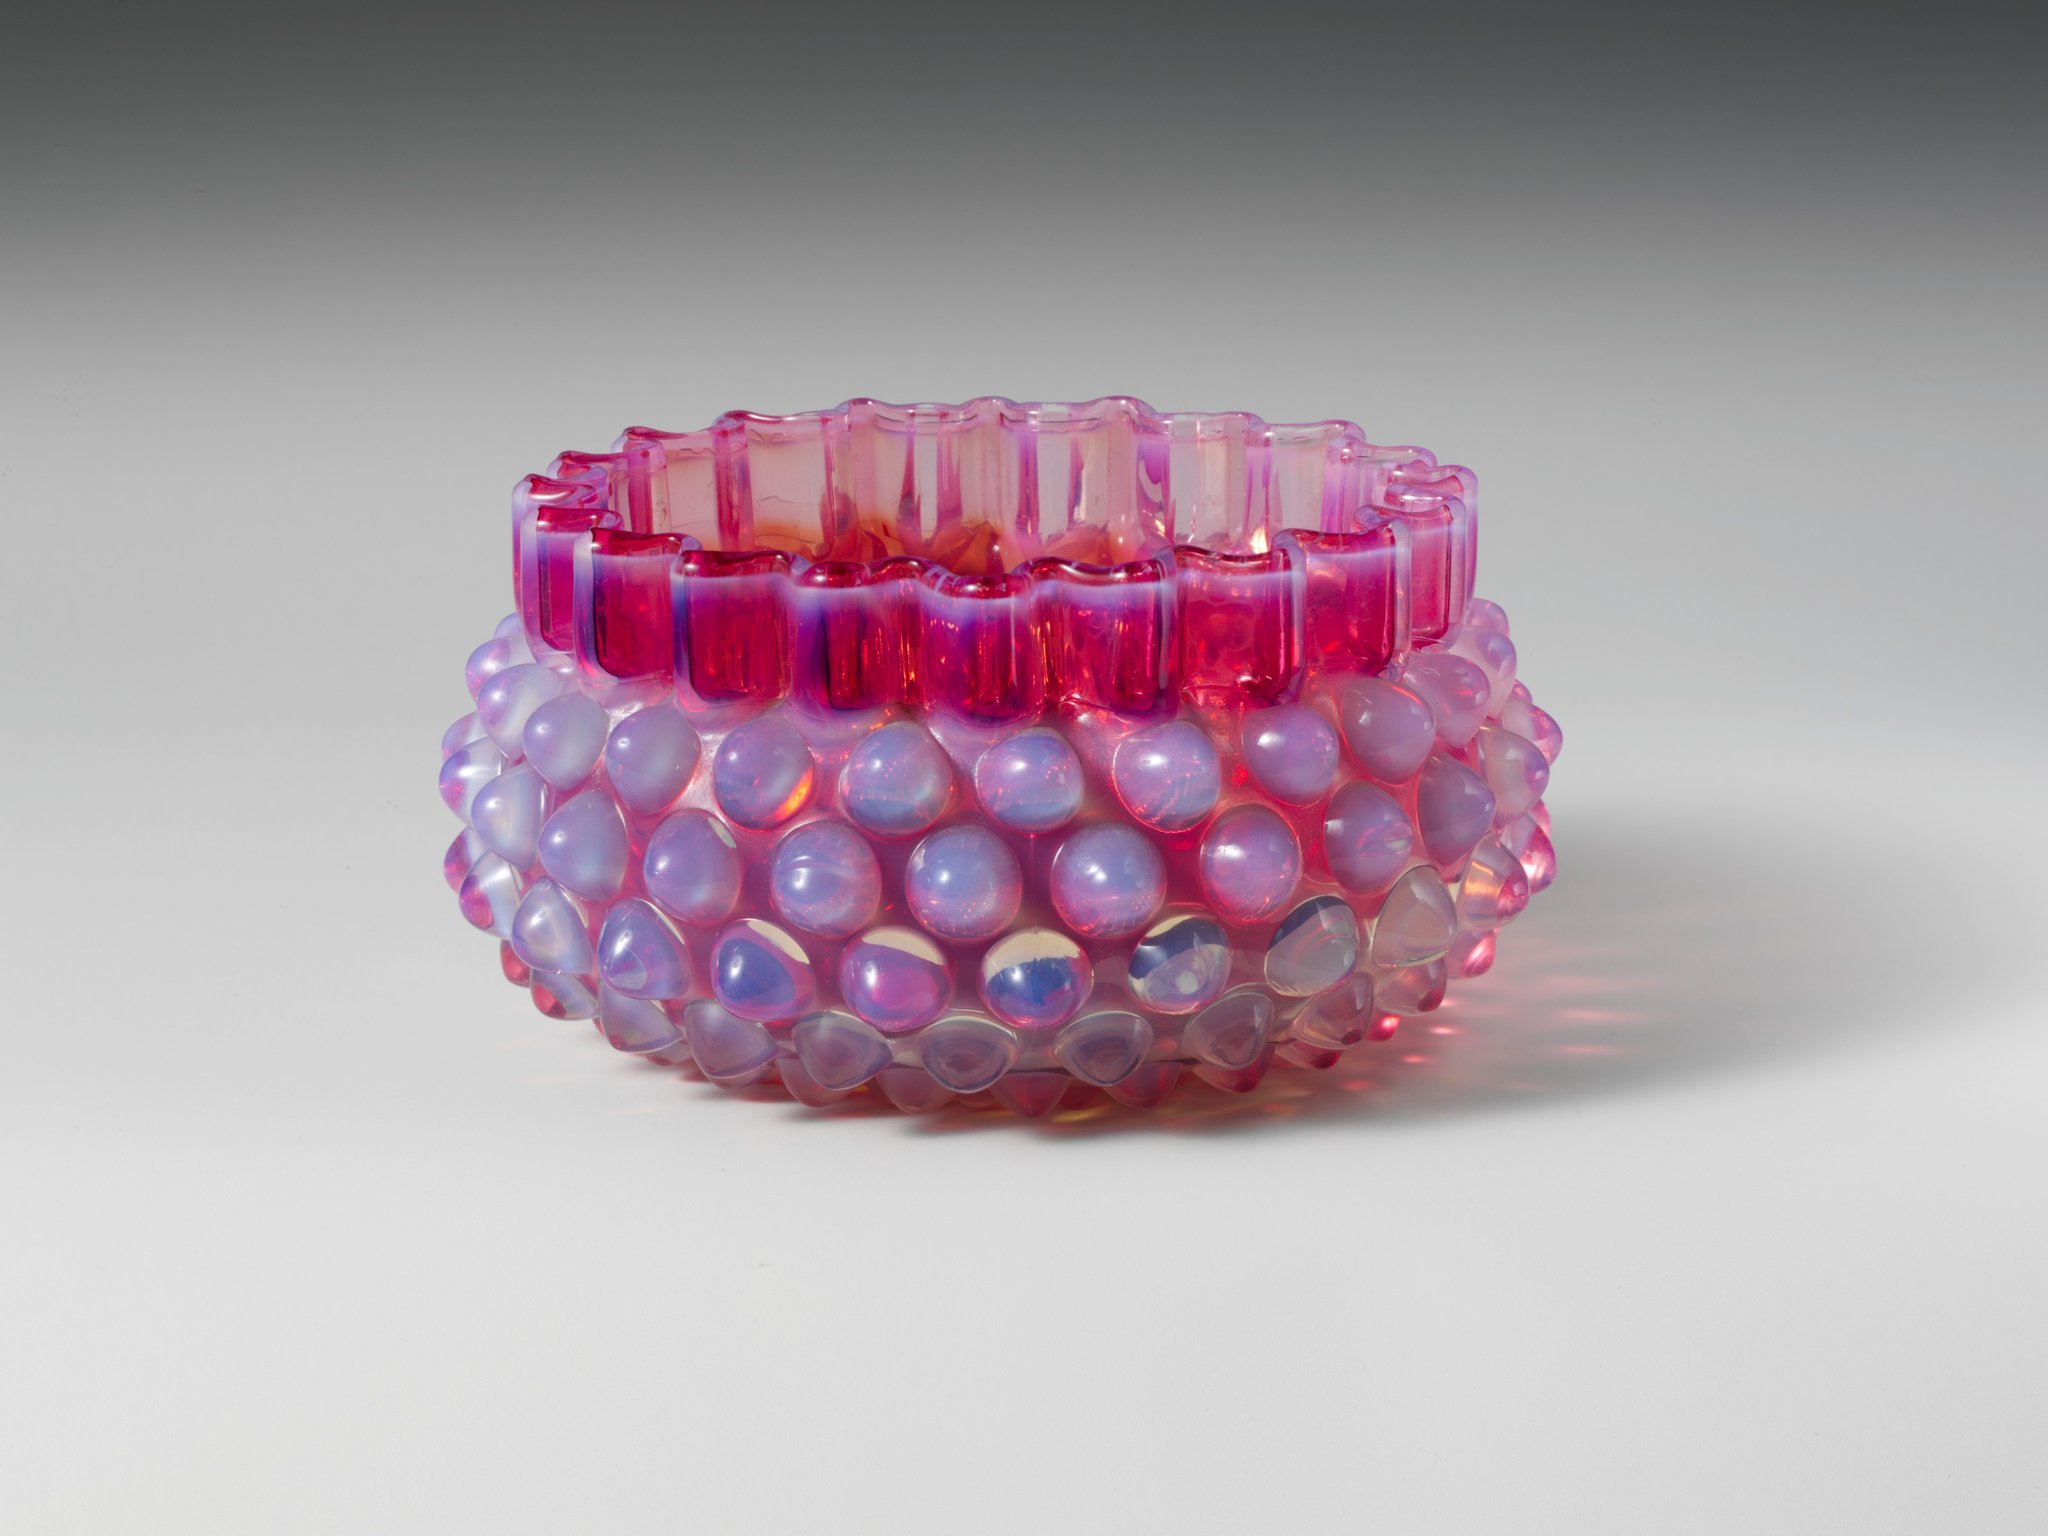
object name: finger bowl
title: Hobnail Finger Bowl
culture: american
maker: hobbs, brockunier and company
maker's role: maker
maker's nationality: american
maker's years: 1863-1891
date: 1886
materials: glass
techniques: pressed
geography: united states